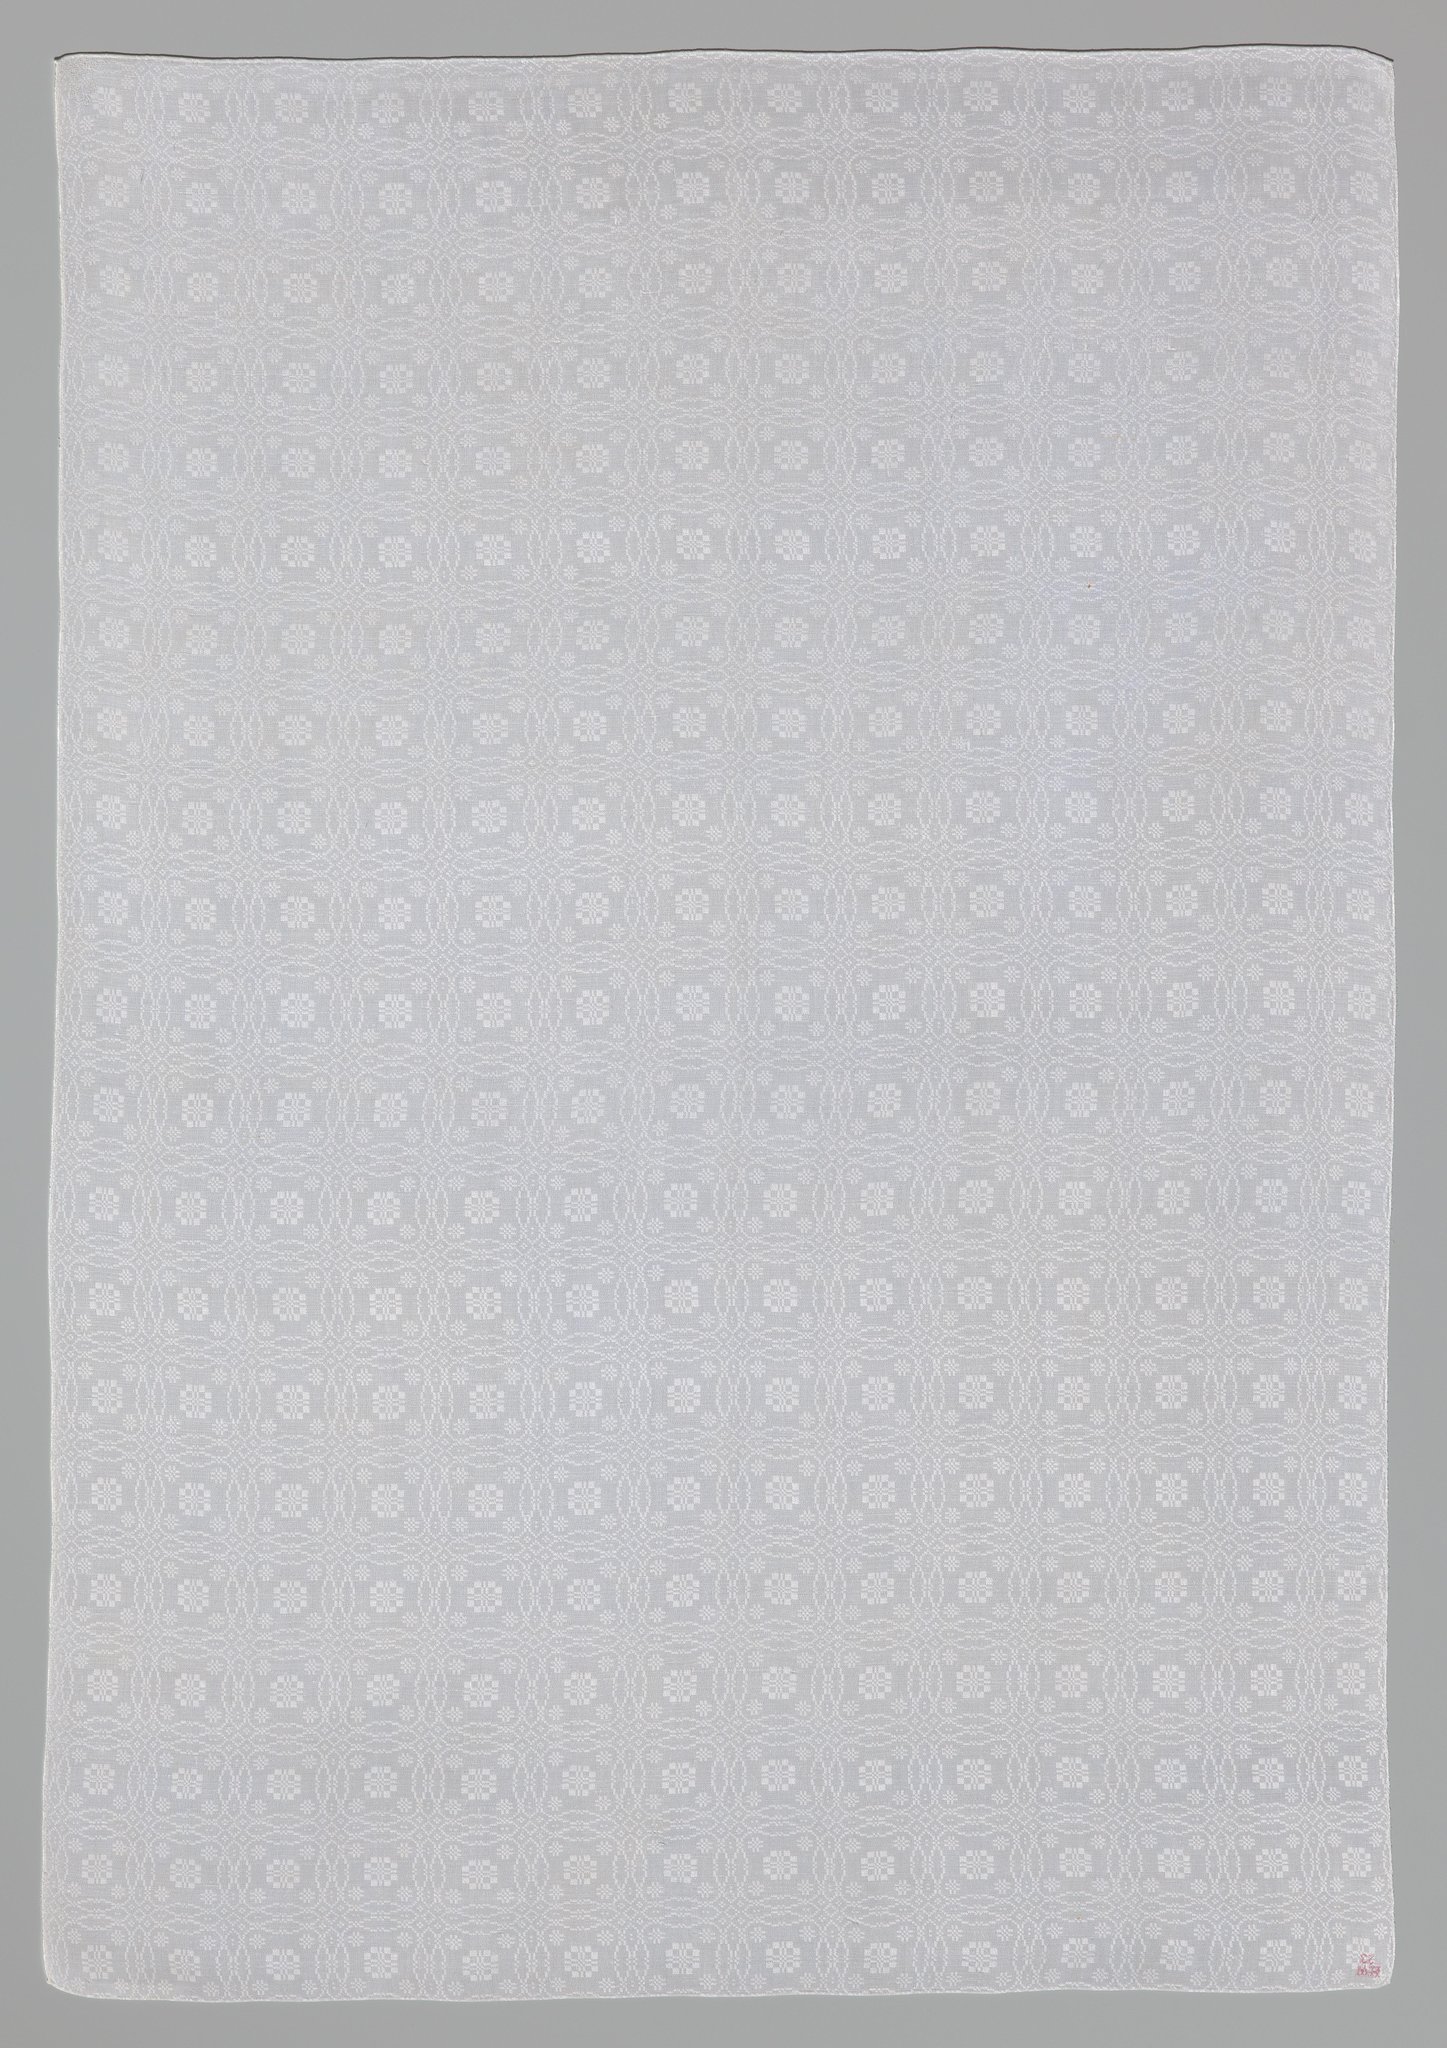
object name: napkin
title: Wit linnen pellen servet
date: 1690-1710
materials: linen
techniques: peeled fabric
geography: northern netherlands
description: Wit linnen pellen servet, gemerkt kroon GS 12 en HW 23.